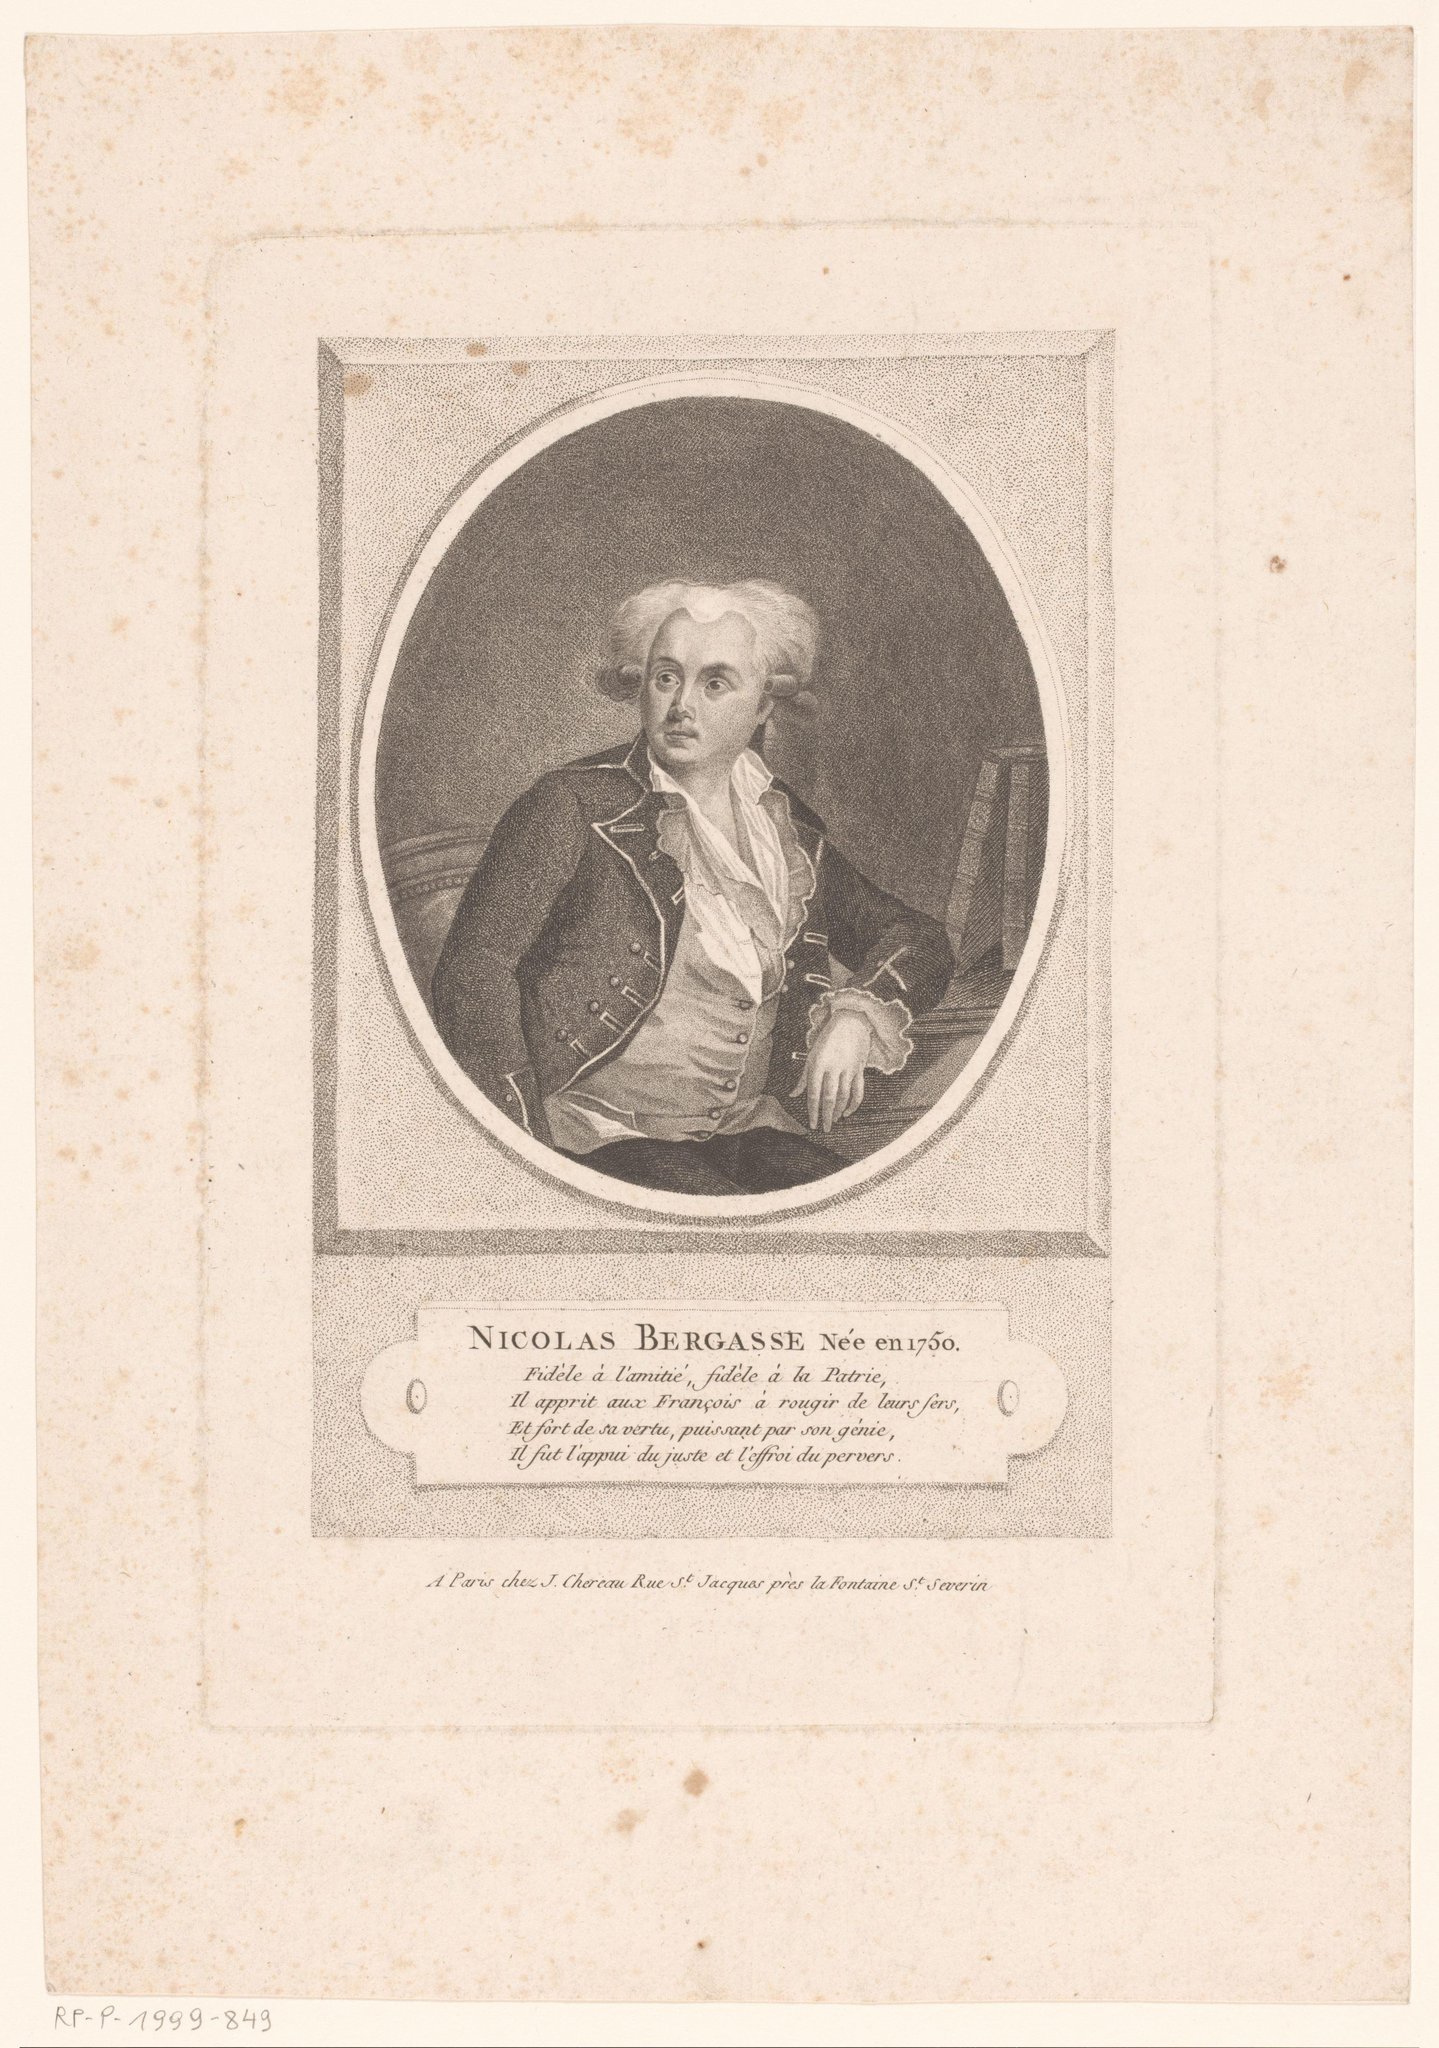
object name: print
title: Portret van Nicolas Bergasse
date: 1775-1832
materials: paper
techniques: stippling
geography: paris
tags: lyon, paris, politician, ornament ~ medallion, historical persons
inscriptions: collector's mark: Lugt 2760, collector's mark: Lugt 2888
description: Mogelijk werd deze prent, gezien de levensdata van de geportretteerde, bij een nazaat van Chéreau uitgegeven.